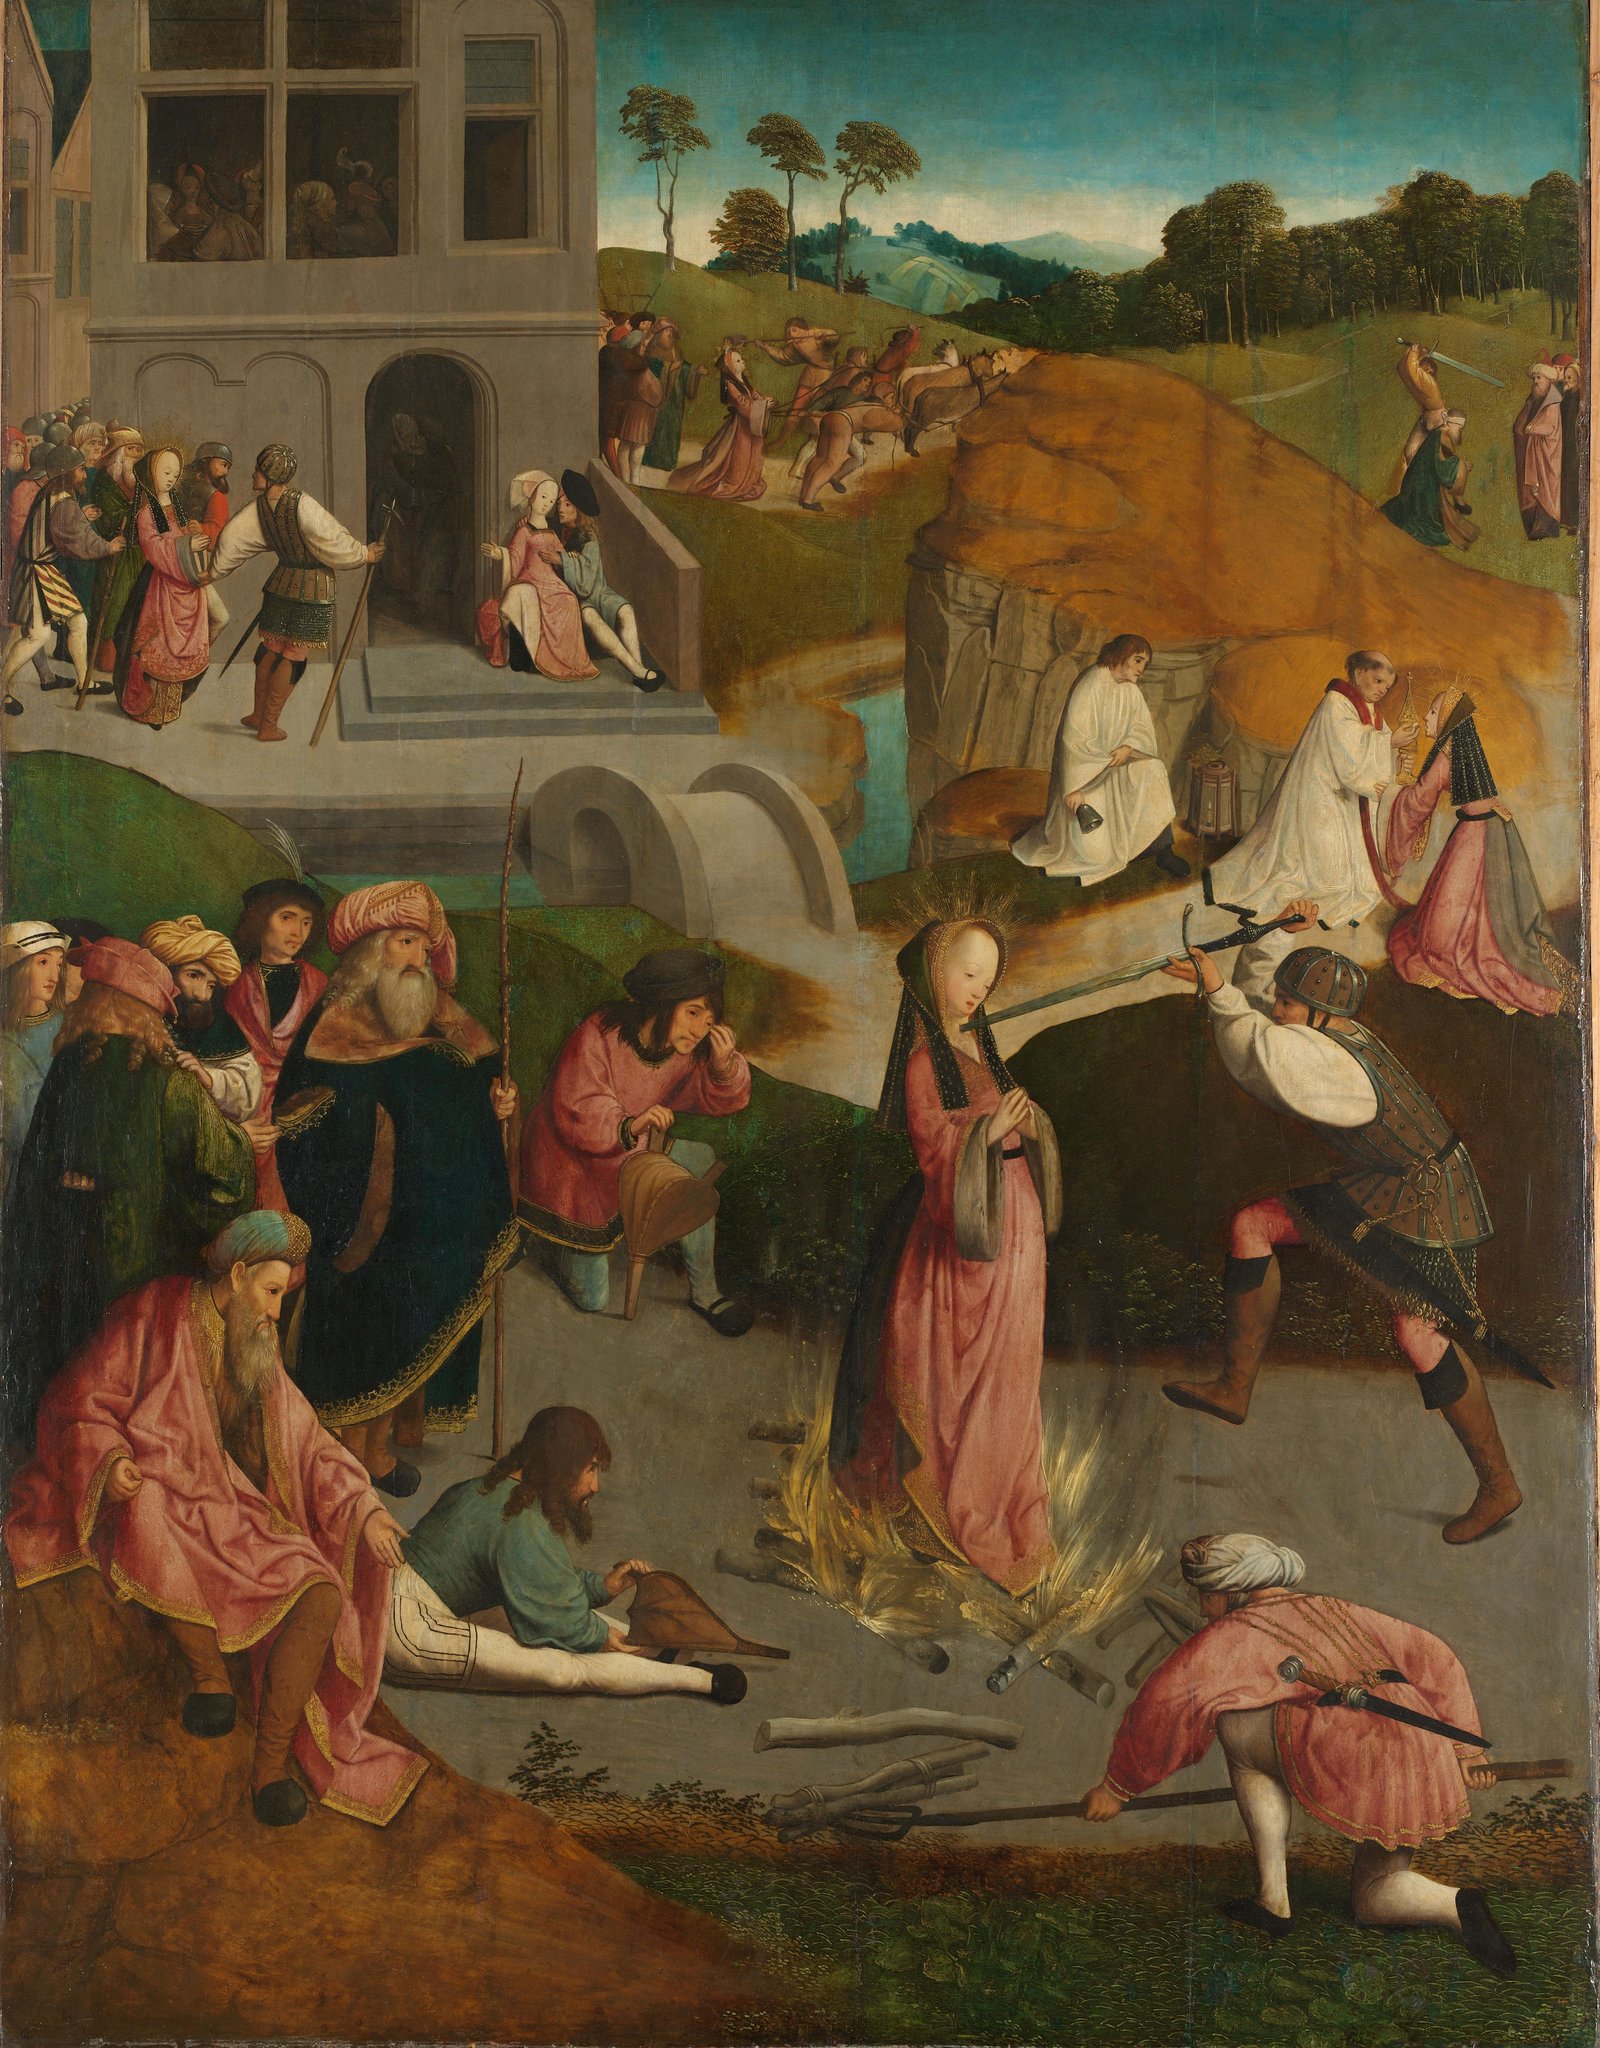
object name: painting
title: The Martyrdom of Saint Lucy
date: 1505-1510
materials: oil, panel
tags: st. lucy is stabbed through the throat with a dagger or a sword, st. lucy is burned at the stake, but the flames do not harm her, st. lucy, tied to a team of oxen, is dragged to a brothel but stands fast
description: After breaking off her engagement to a Roman consul to become a Christian, Lucy endured many tortures, yet she remained steadfast. She was eventually executed by the sword, as seen here. This panel was part of an altar dedicated to the saint.